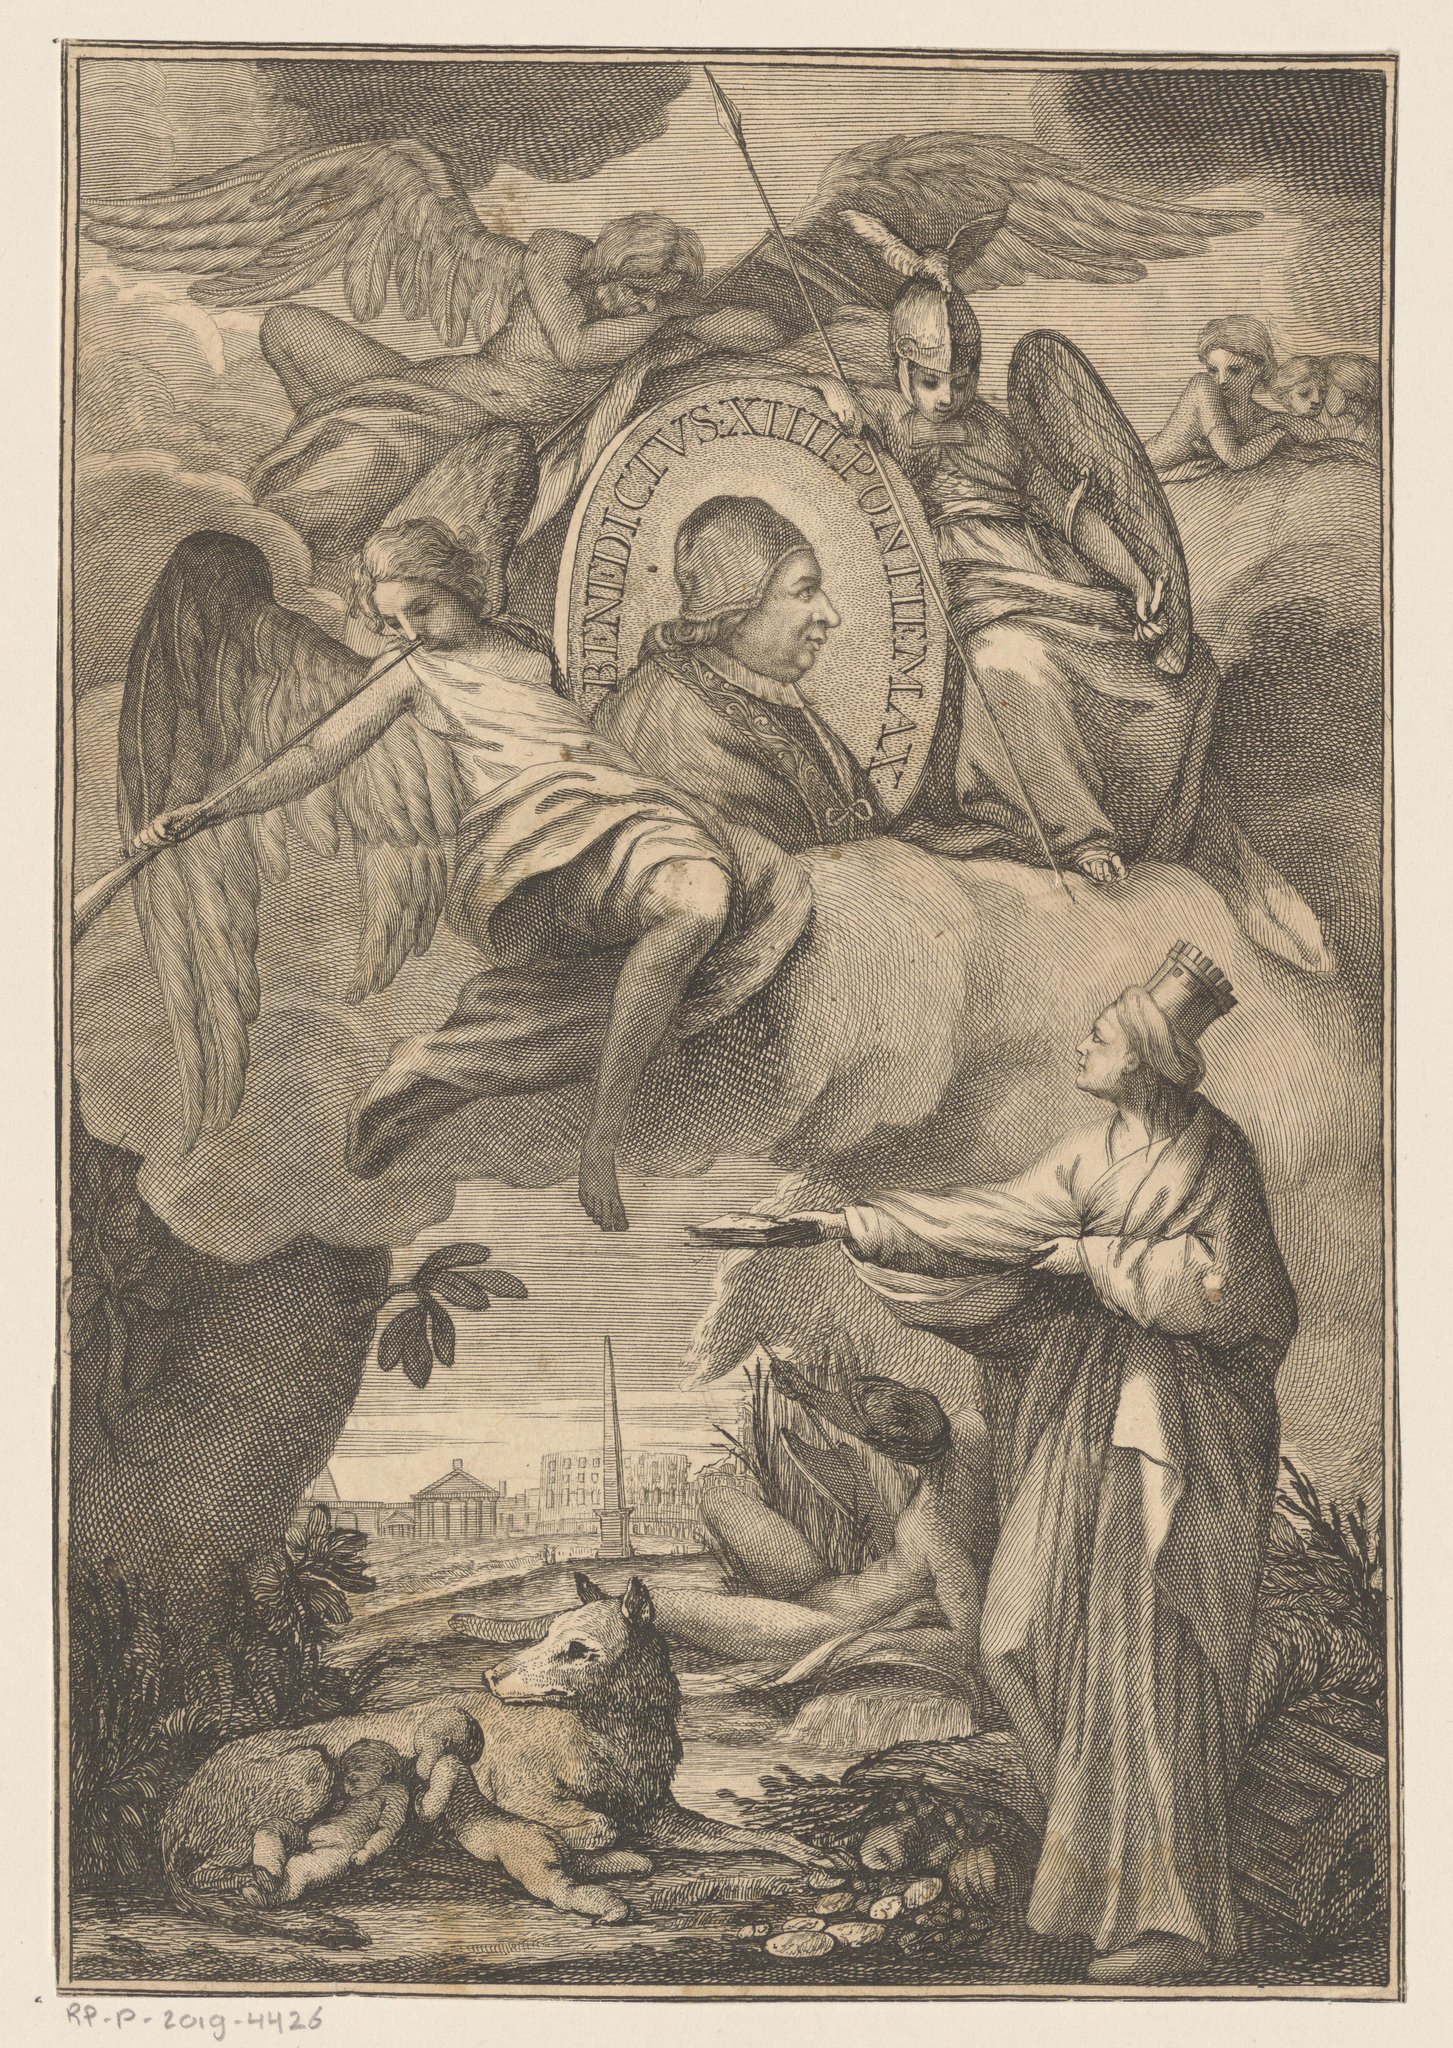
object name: print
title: Portret van paus Benedictus XIV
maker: Anonymous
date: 1740-1799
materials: paper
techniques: engraving, etching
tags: rome, clergyman, benedictus xiv, (story of) minerva (pallas, athena), historical persons, (story of) romulus and remus, cities represented allegorically or symbolically, fame; 'fama', 'fama buona', 'fama chiara' (ripa), pope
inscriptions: collector's mark: Lugt 2228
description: Portret omringd door Minerva, Fama, en de personificatie van tijd, met onderaan Romulus en Remus, een gezicht op Rome en de personificaties van de Tiber en Rome.